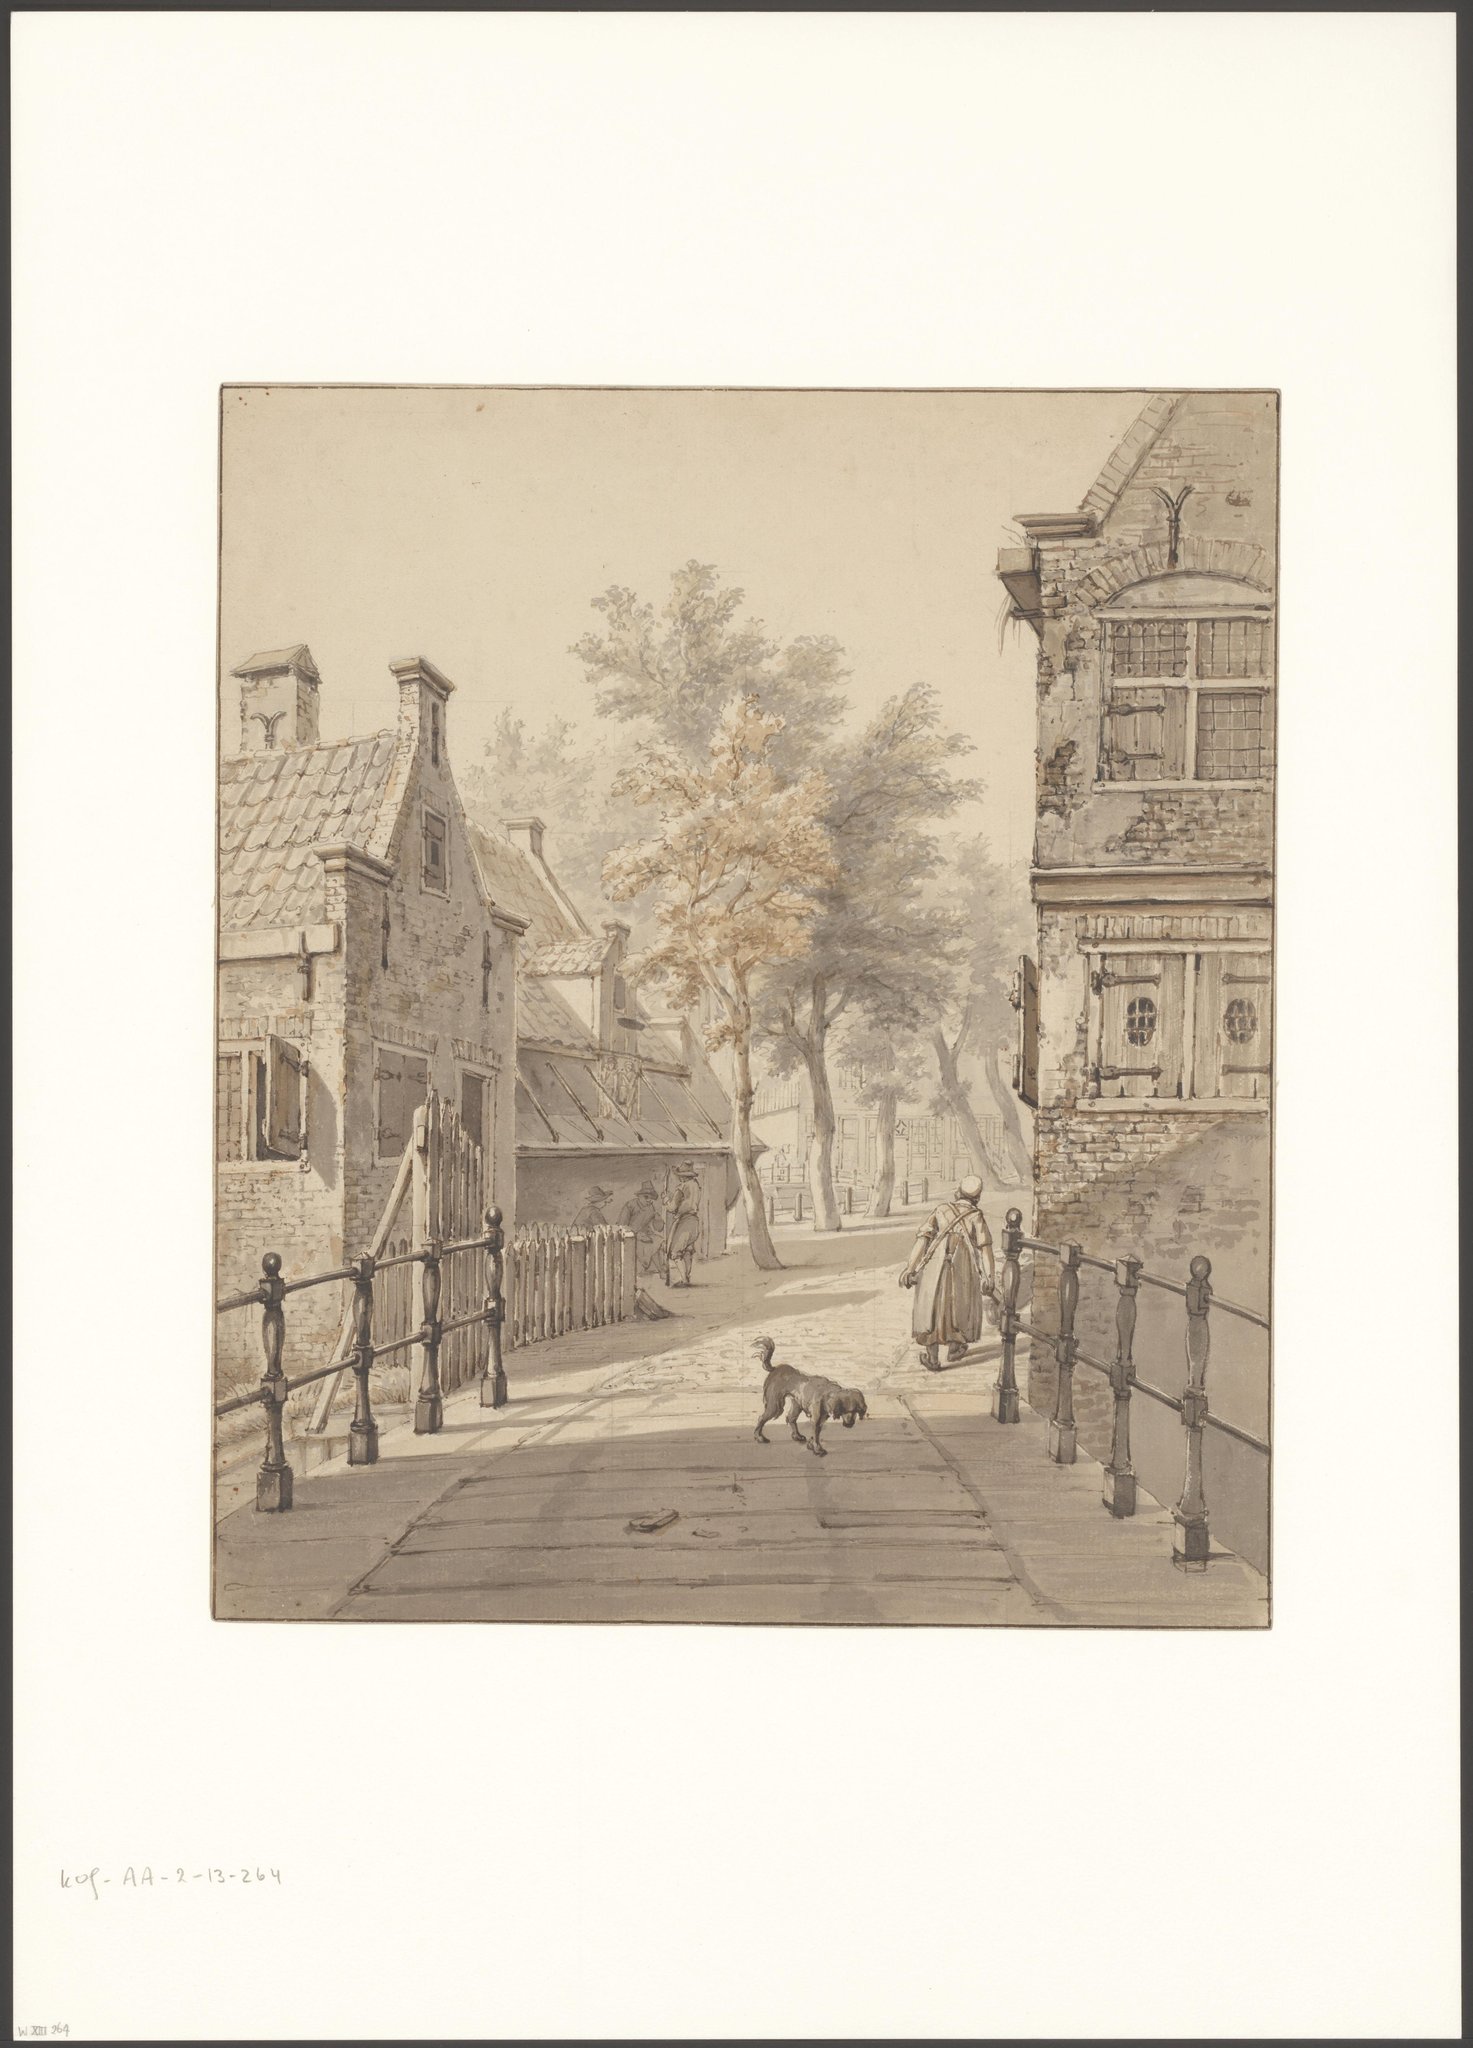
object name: drawing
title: Gezicht op het Bierdragershuisje bij de Begijnensloot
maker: carel lodewijk hansen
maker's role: draughtsman, painter, print maker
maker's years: 1765-1840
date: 1775-1840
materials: ink, paper, pencil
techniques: brush, pen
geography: amsterdam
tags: city-view in general; 'veduta', canal, bridge in city across river, canal, etc., street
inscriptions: collector's mark: Lugt 800a, inscription: ‘Bierdragershuisje op 't Spui te Amsterdam / door C. L. Hansen’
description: Tekening binnen de Atlas Van Eck ingedeeld op wijknummer 13.